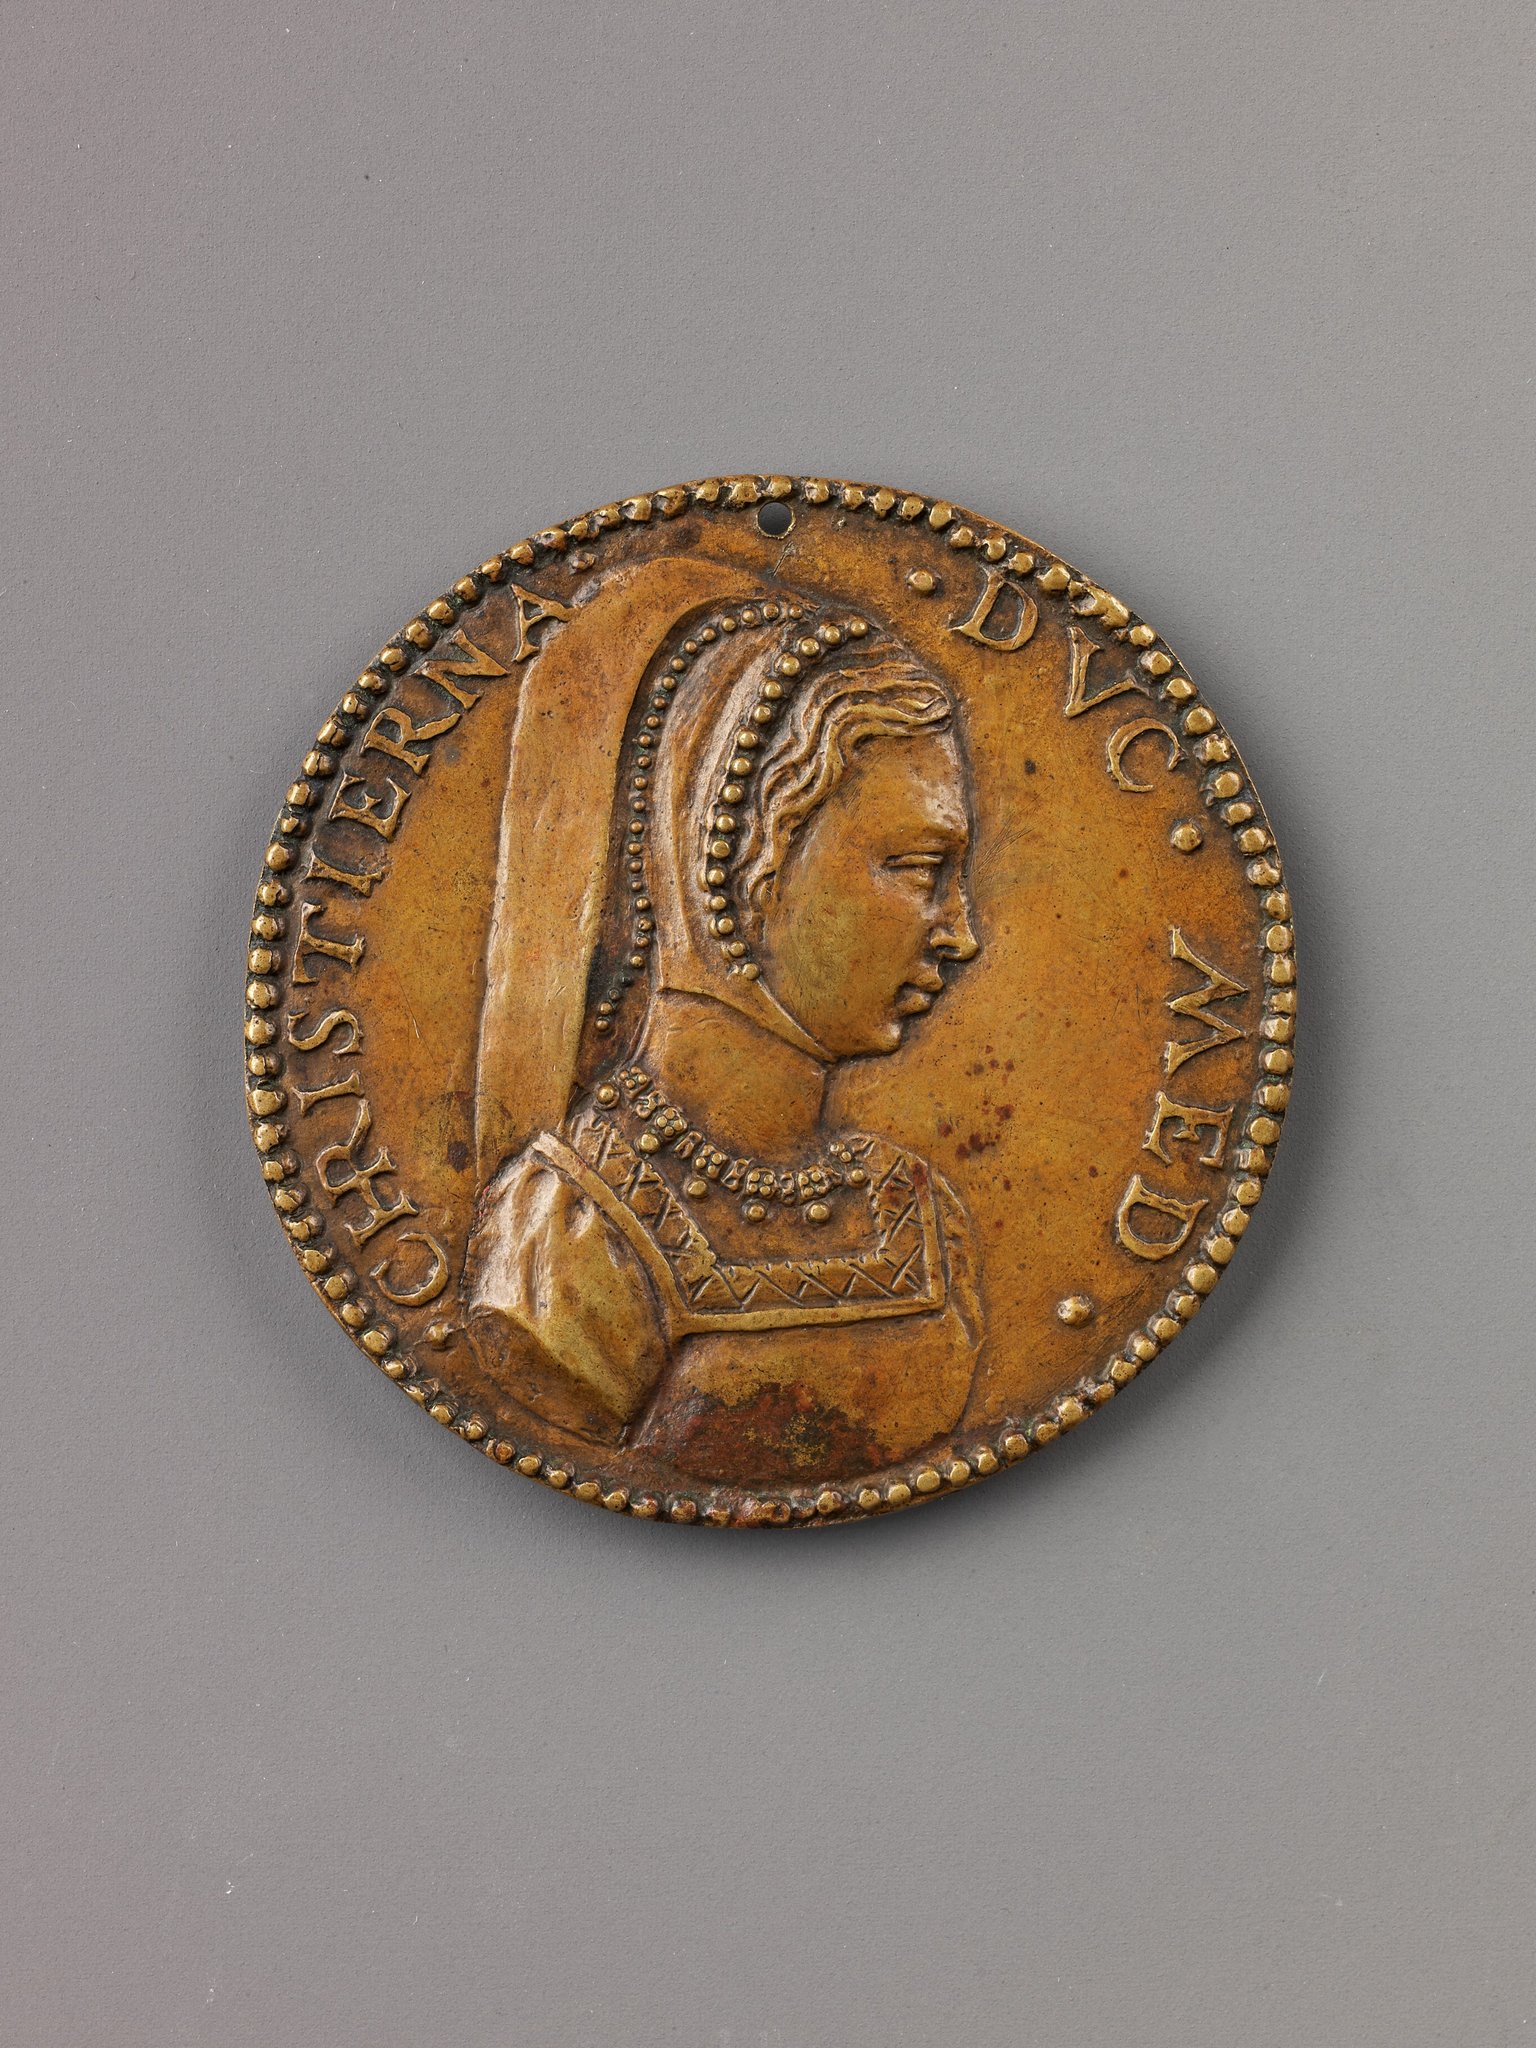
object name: medal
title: Portrait medal of Christine of Denmark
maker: jacopo nizolla da trezzo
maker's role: artist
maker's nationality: italian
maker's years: 1515-1589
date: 1533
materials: bronze, copper alloy, patina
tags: portraits,profiles,women